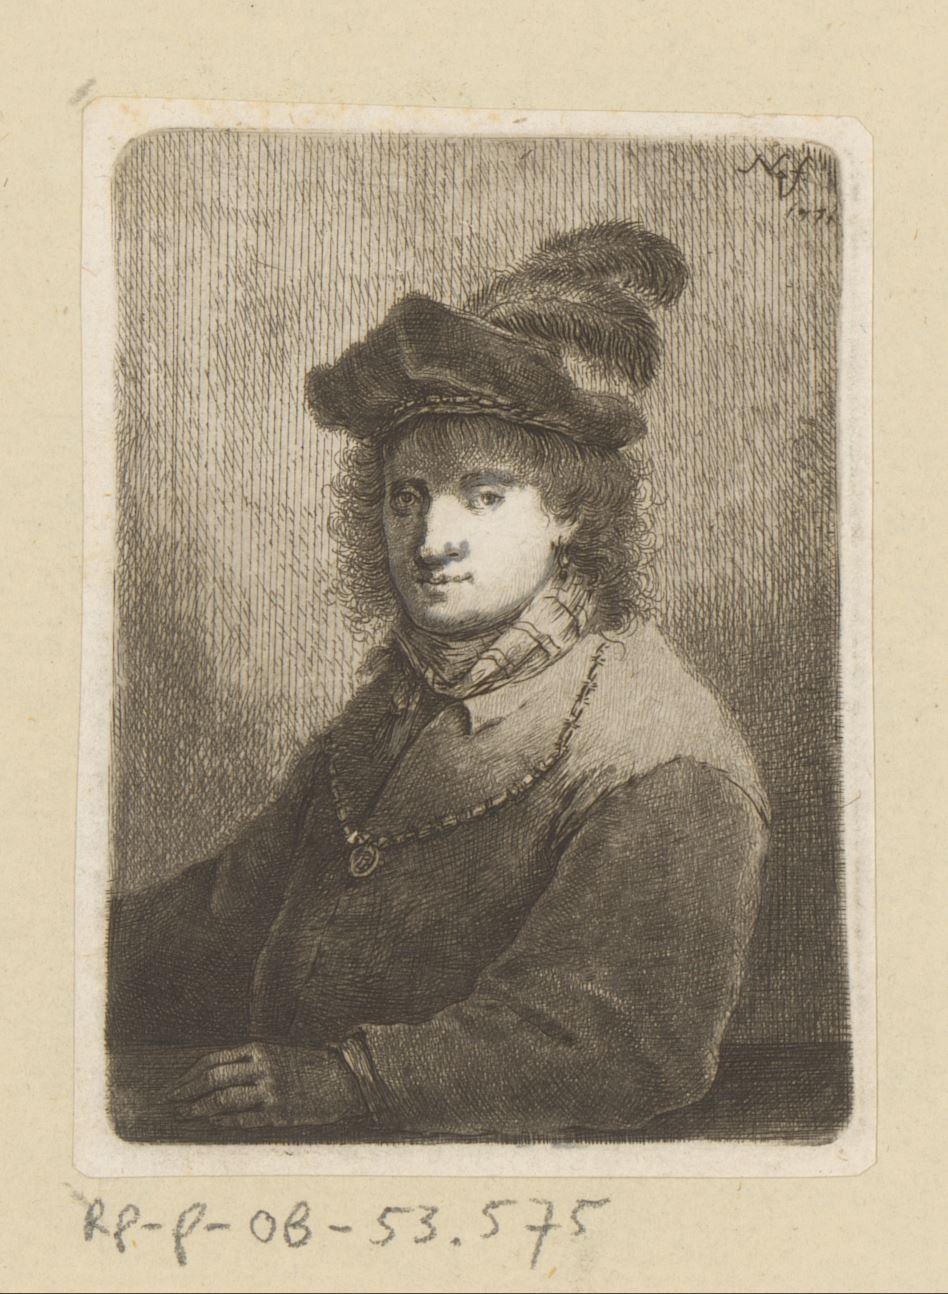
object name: print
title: Man met muts met veren en ketting om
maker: johann andreas benjamin nothnagel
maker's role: print maker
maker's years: 1729-1804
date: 1771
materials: paper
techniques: etching, intaglio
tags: sitting figure, head-gear: cap (+ men's clothes), medals and other marks of military honour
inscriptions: collector's mark: Lugt 240